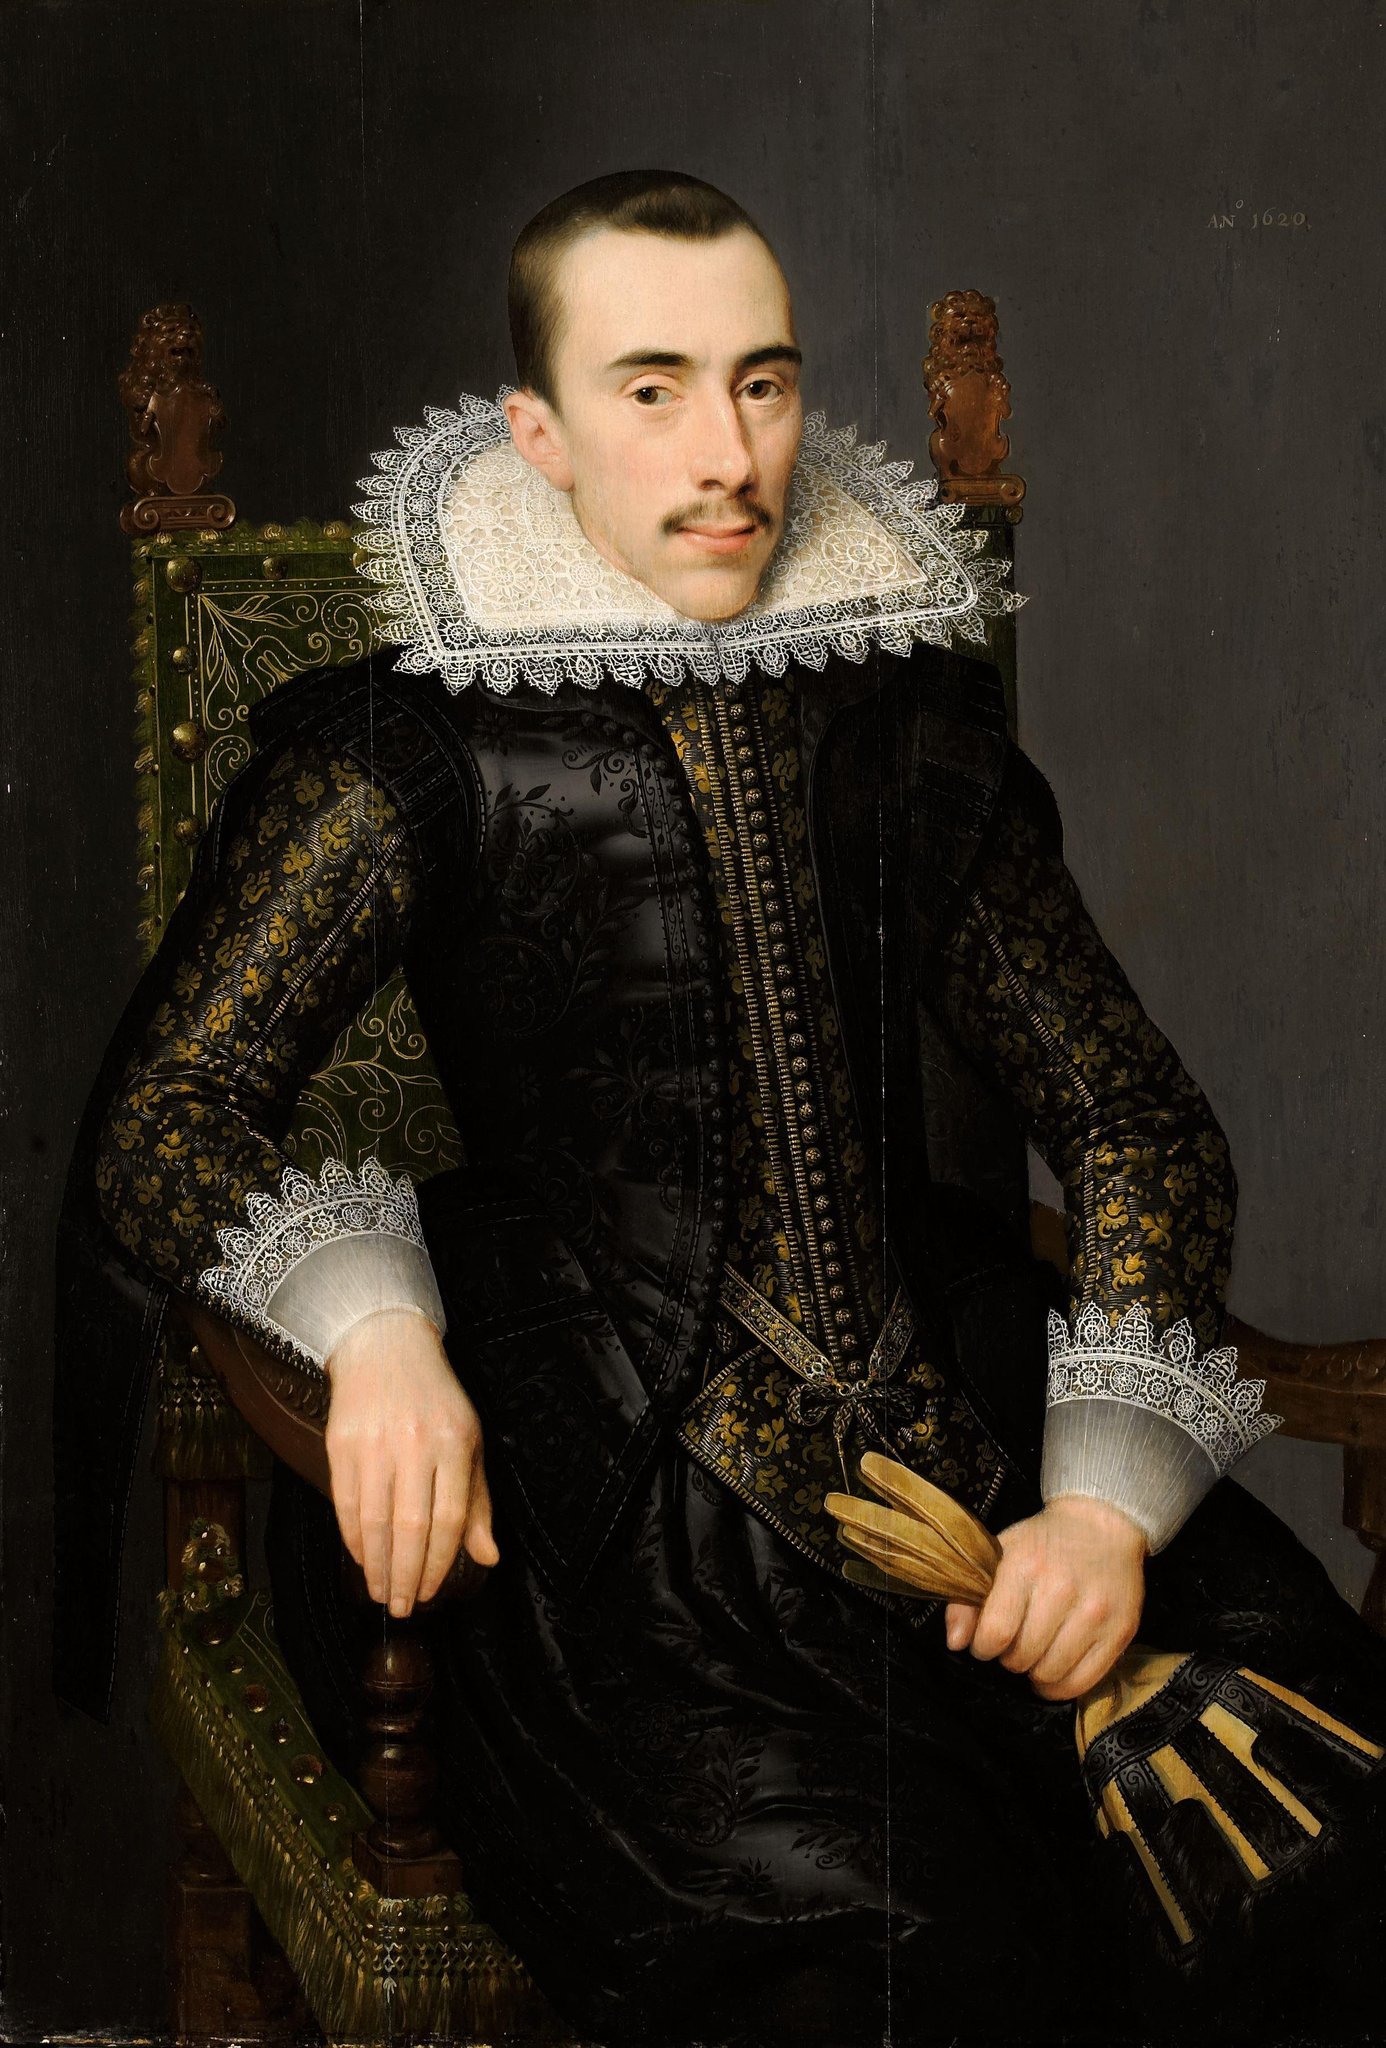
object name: painting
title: Portrait of a Man, possibly Walterus Fourmenois (1596-1653)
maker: salomon mesdach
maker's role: painter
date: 1620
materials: oil, panel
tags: middelburg, historical persons, historical persons not known by name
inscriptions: coat of arms, on the reverse: quartered, 1 and 4, a silver chevron with three gold stars on a blue field, and three black martlets in a gold chief; 2 and 3, a standing black harrier on a gold field, inscription, on the reverse: ‘Boudaen Courten. / Zoon van Mathias en Margarita Courten. / Geb: / Overl:’, date, upper right: ‘ANº 1620.’, inscription, on the reverse: ‘30’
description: Portret van een man, mogelijk Walterus Fourmenois (1596-1653). Zittend in een stoel, de handschoenen in de linkerhand. Op de achterzijde het familiewapen en het cijfer 30.